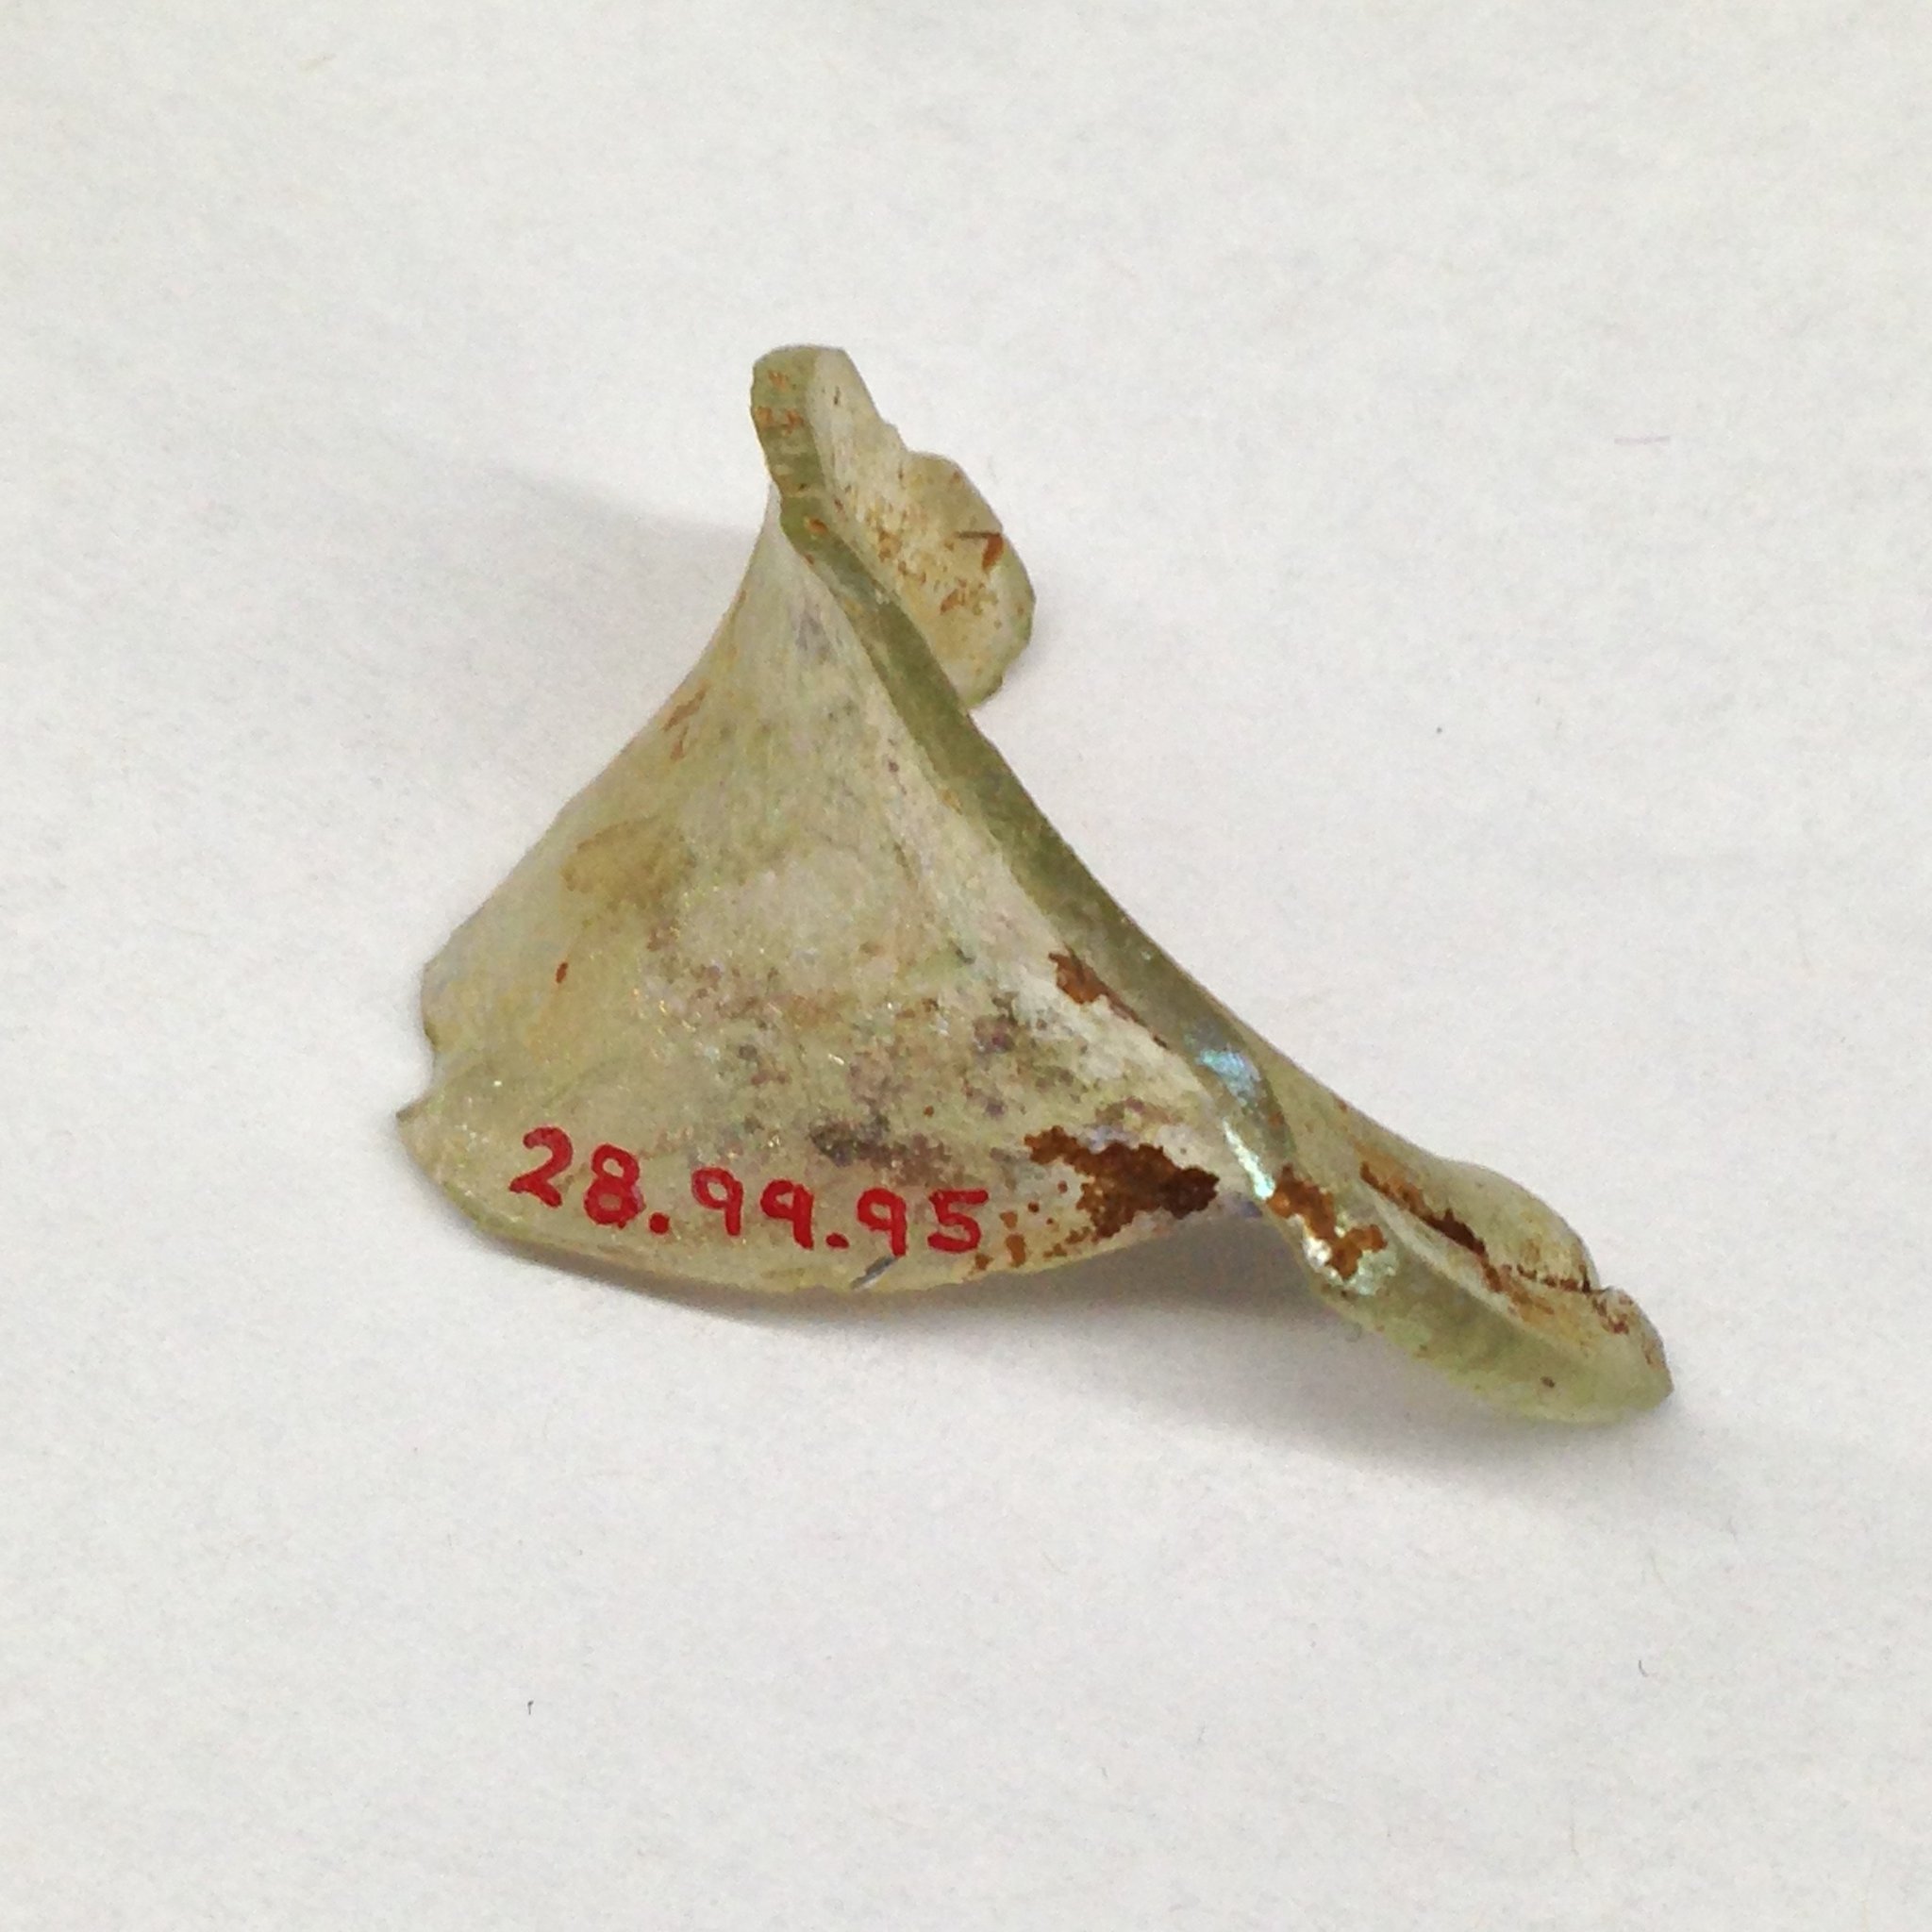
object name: fragment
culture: european or middle eastern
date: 1150-1250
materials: ceramic, glass